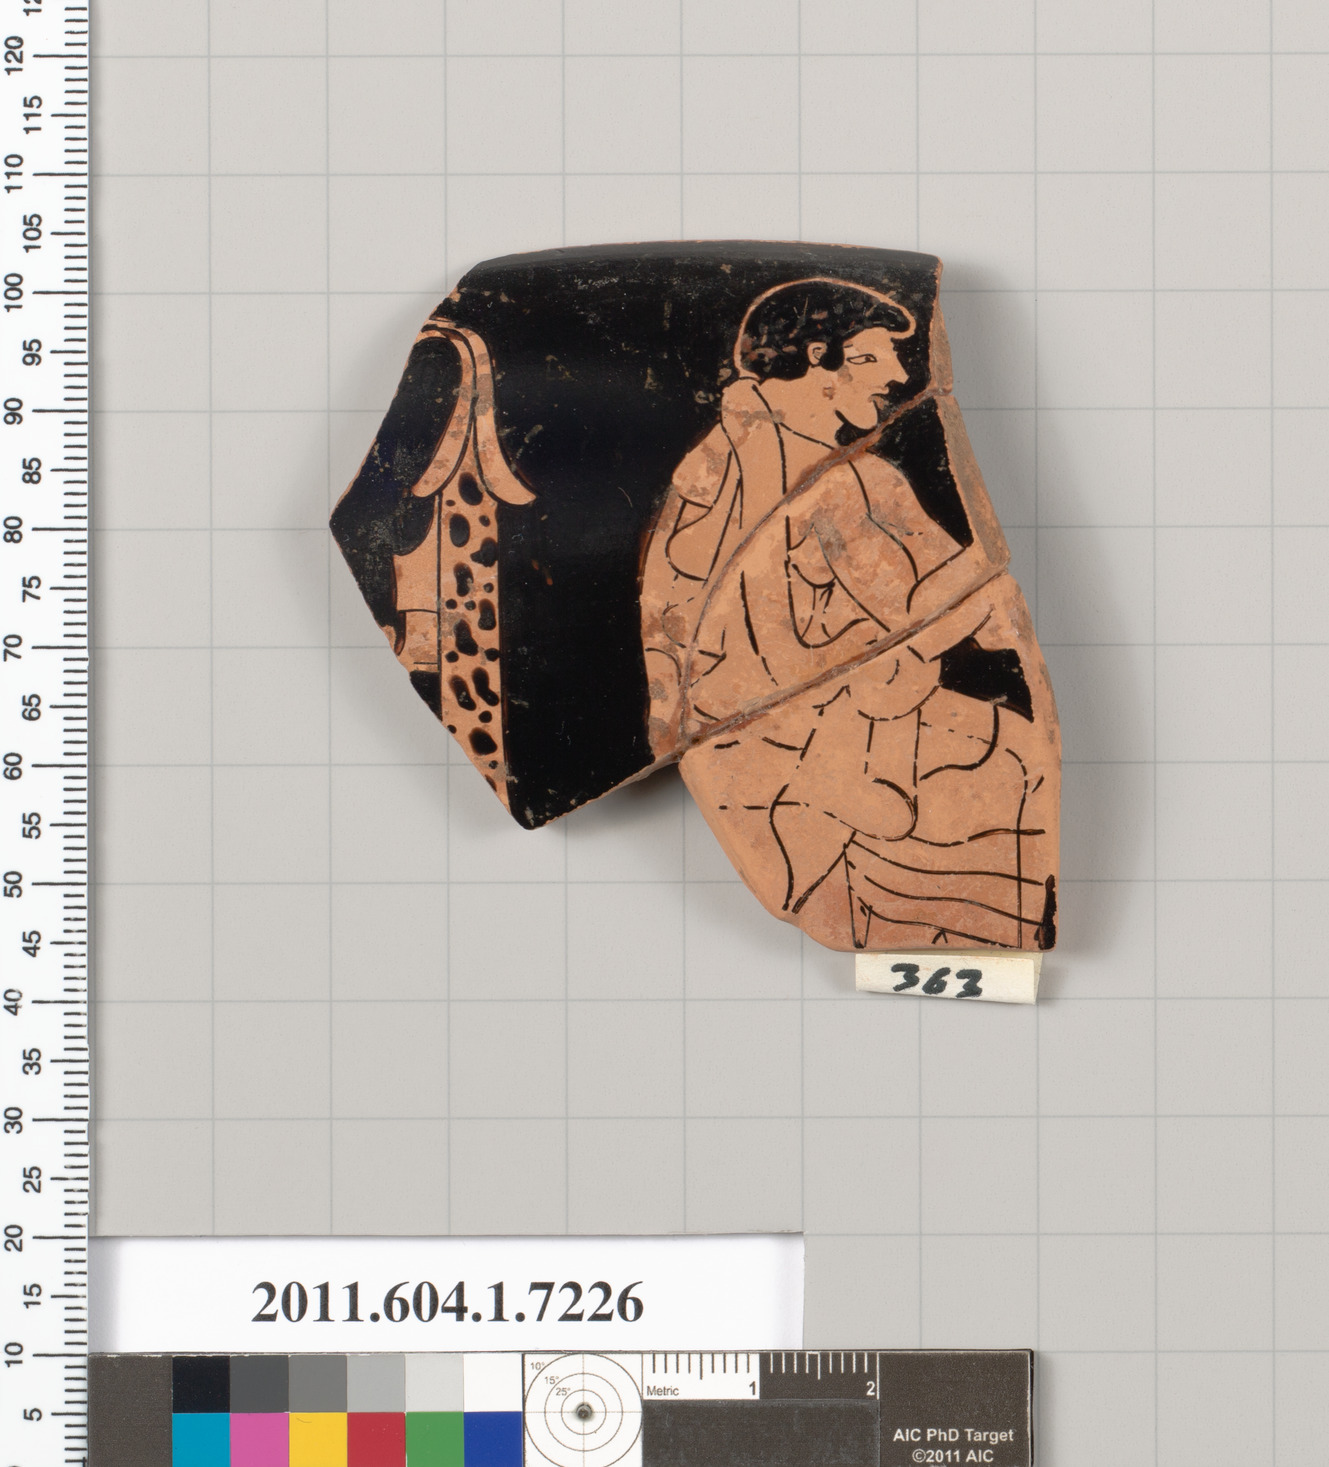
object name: kylix fragment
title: Terracotta fragment of a kylix (drinking cup)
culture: greek, attic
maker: makron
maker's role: artist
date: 500-480 BCE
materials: terracotta